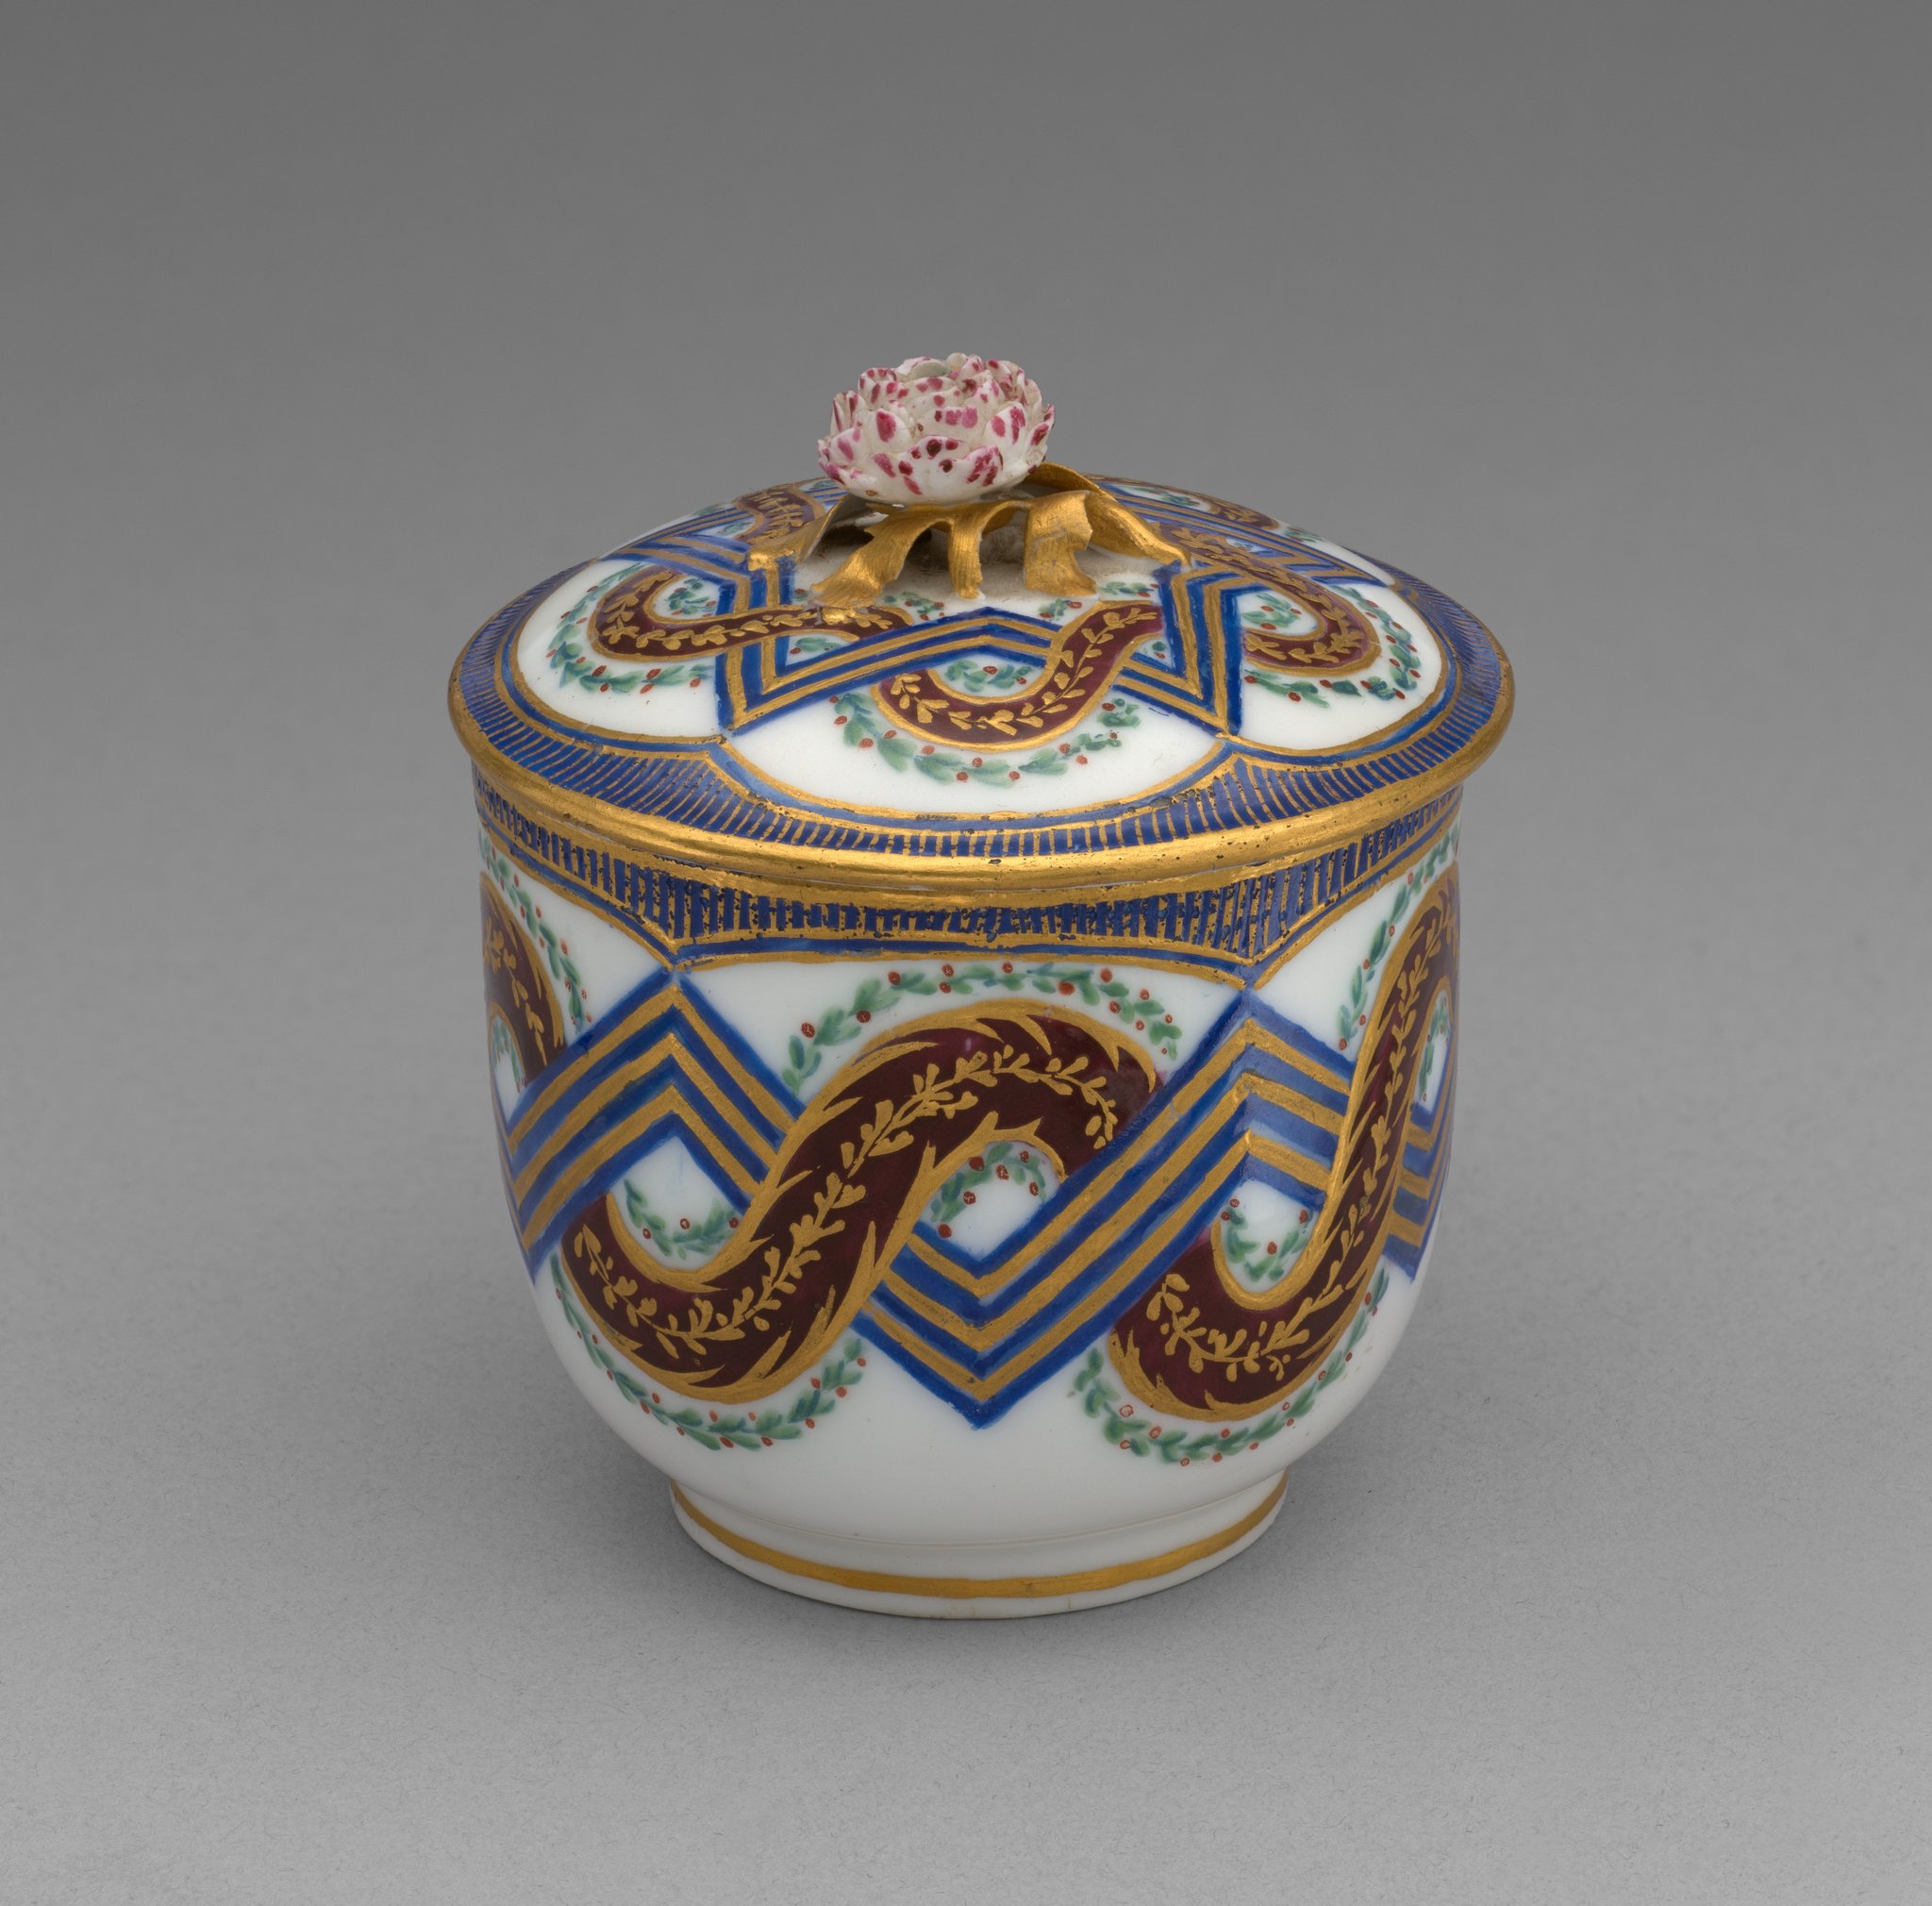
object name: sugar bowl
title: Covered sugar bowl (pot à sucre Calabre) (part of a déjeuner service)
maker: sèvres manufactory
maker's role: maker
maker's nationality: french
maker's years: 1740-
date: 1763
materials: soft paste porcelain